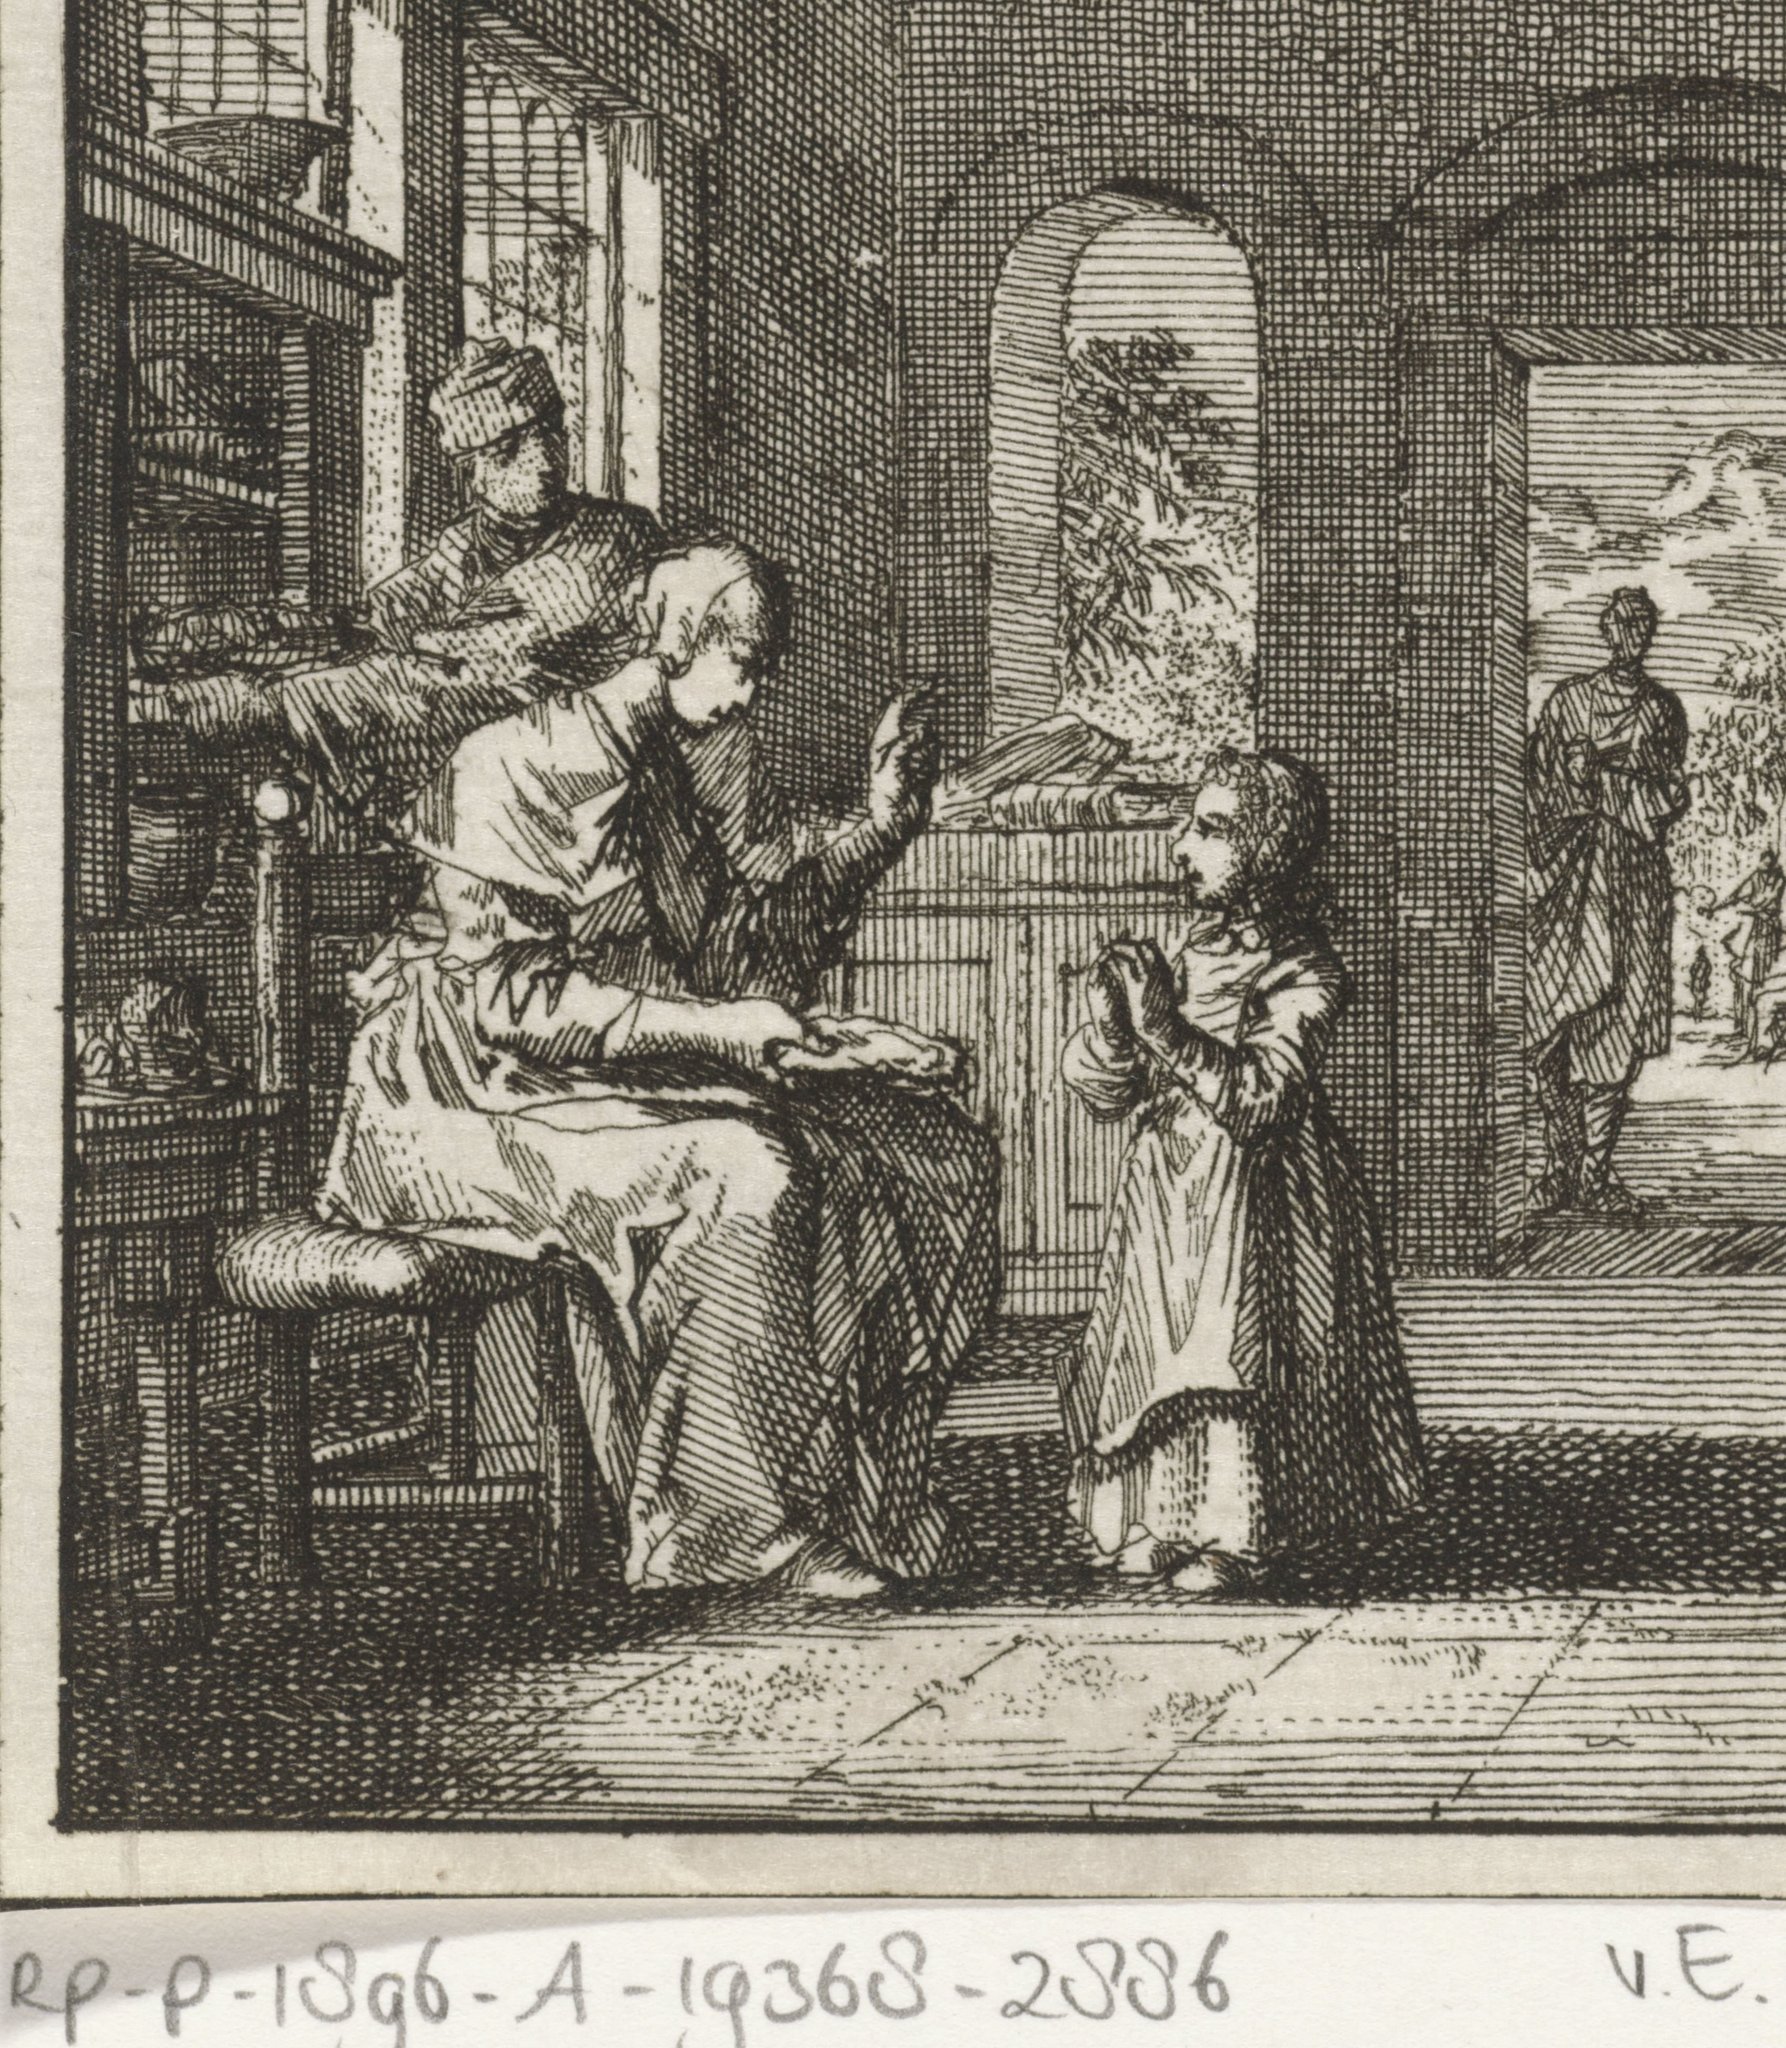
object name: print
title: Het Kindje Bid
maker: jan luyken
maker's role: draughtsman, print maker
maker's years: 1649-1712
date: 1712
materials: paper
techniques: etching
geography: amsterdam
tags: one person praying (+ variant), mother and baby or young child, growing up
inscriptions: collector's mark: Lugt 2228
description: Proefdruk van illustratie uit: Luyken, Jan. Des menschen begin, midden en einde. Amsterdam: Wed. Pieter Arentsz II en Cornelis van der Sys, 1712, p. 39.